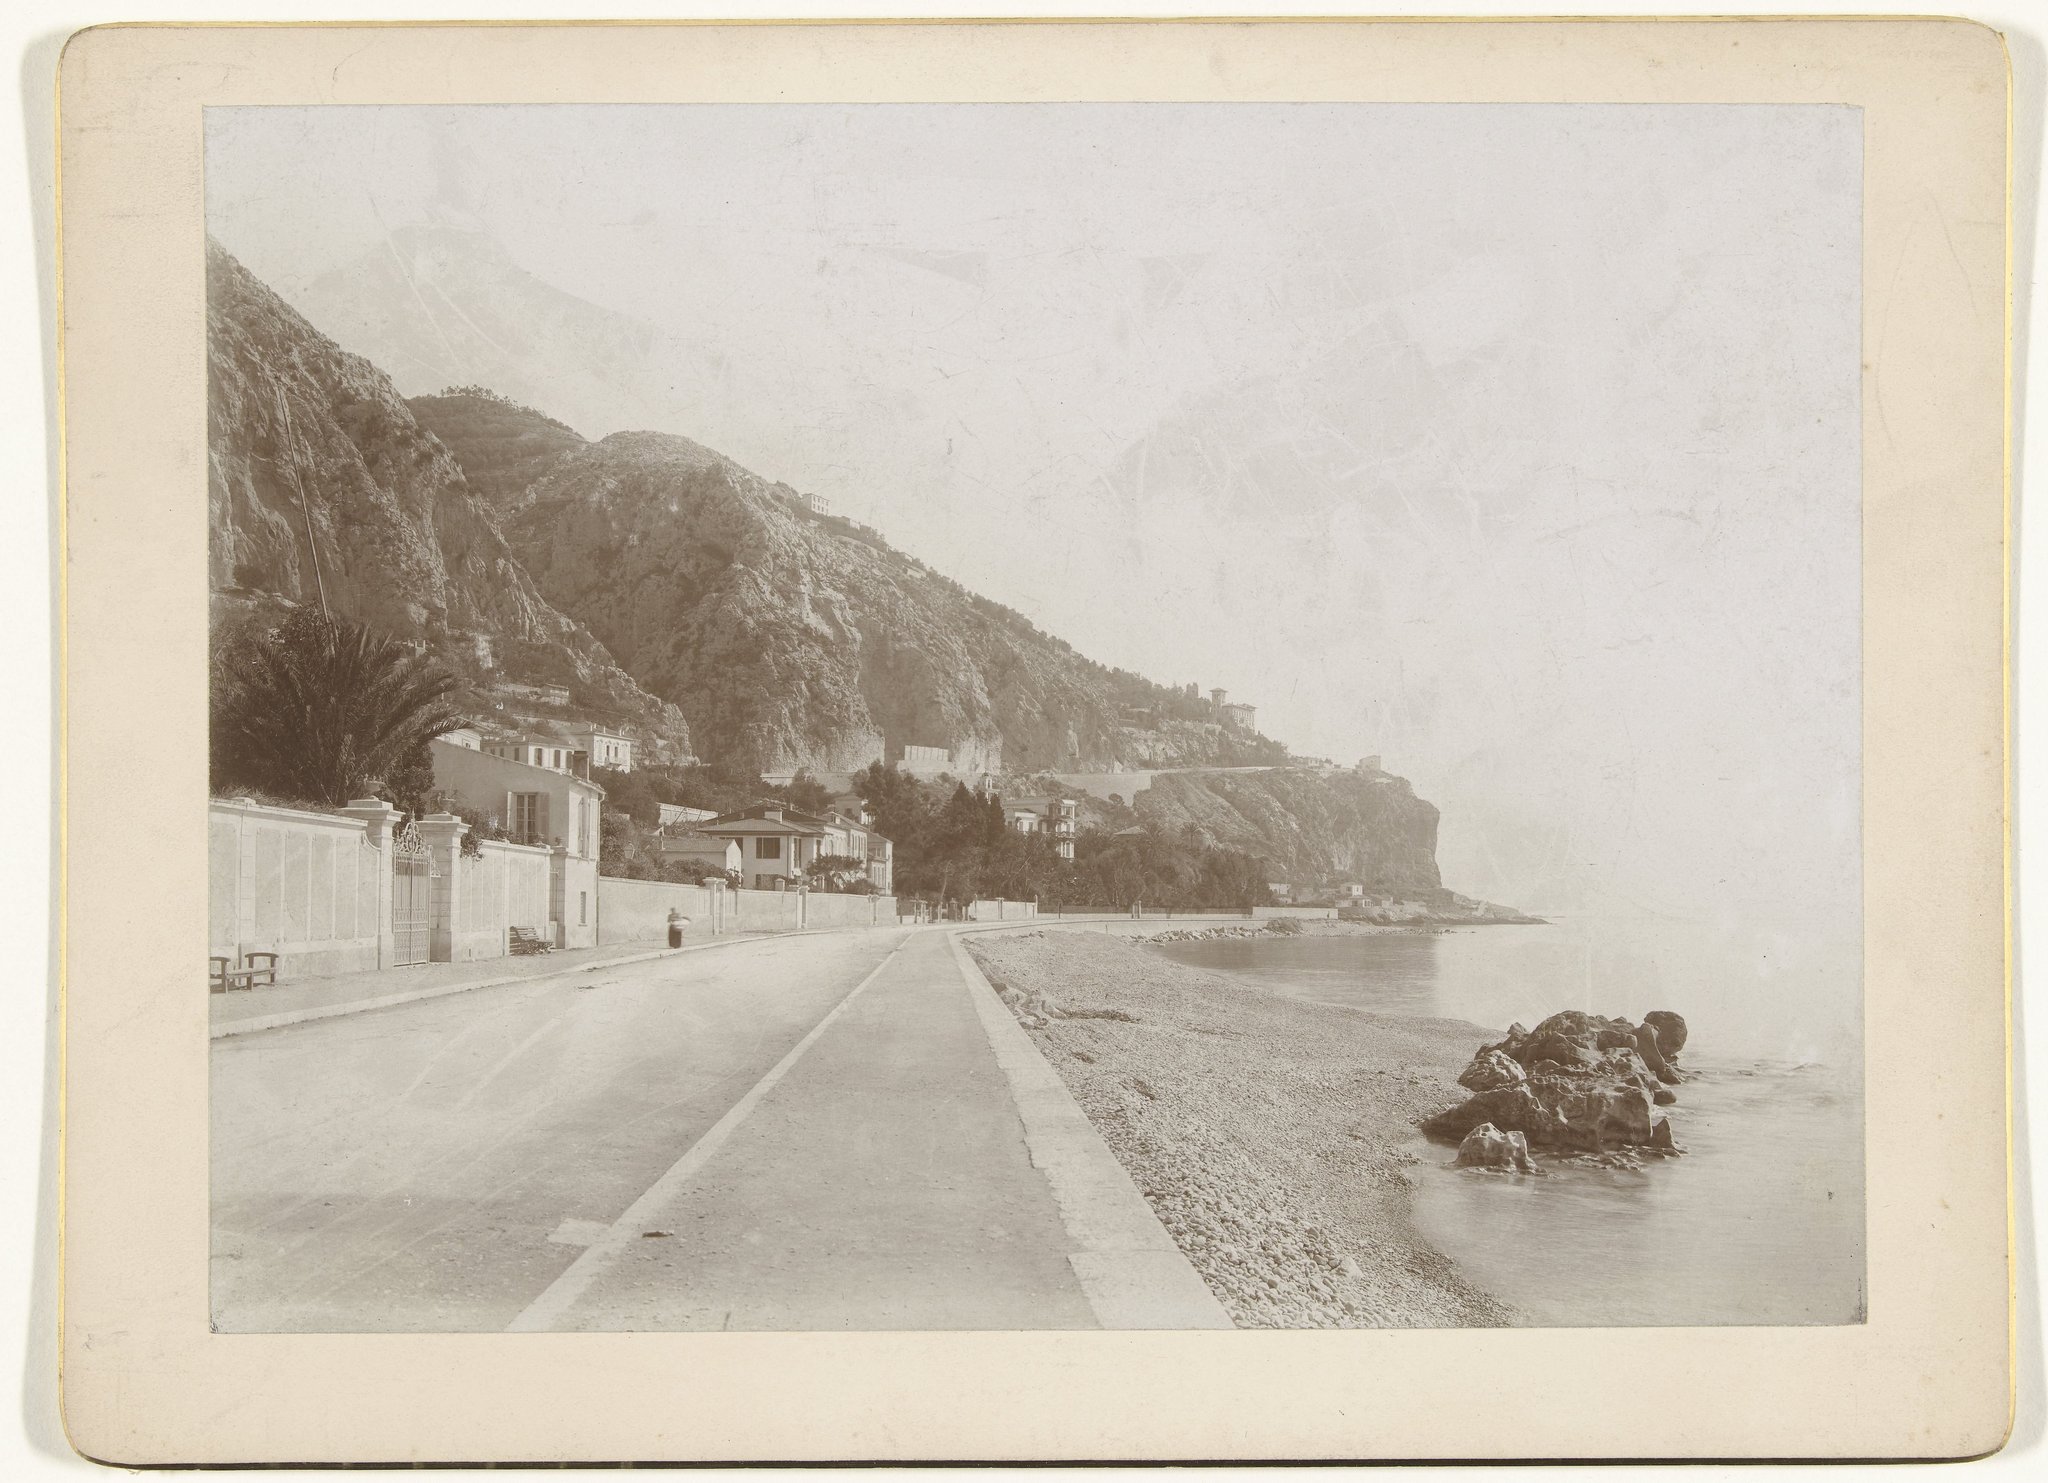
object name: photograph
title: Gezicht op de Promrenade St. Louis, Frankrijk, met bergen en kust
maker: henry pauw van wieldrecht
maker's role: fotograaf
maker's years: 1863-1912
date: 1896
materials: cardboard, photographic support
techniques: gelatin silver print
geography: france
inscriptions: annotation: ‘No. 1151. - 1896.’